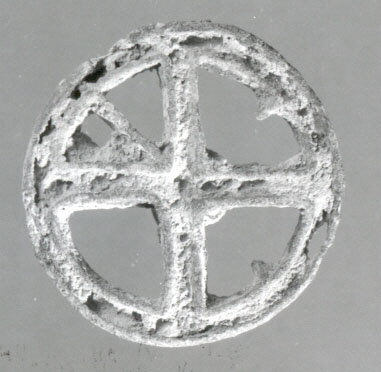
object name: stamp seal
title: Compartmented stamp seal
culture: bactria-margiana archaeological complex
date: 2333-1668 BCE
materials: copper alloy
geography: bactria-margiana